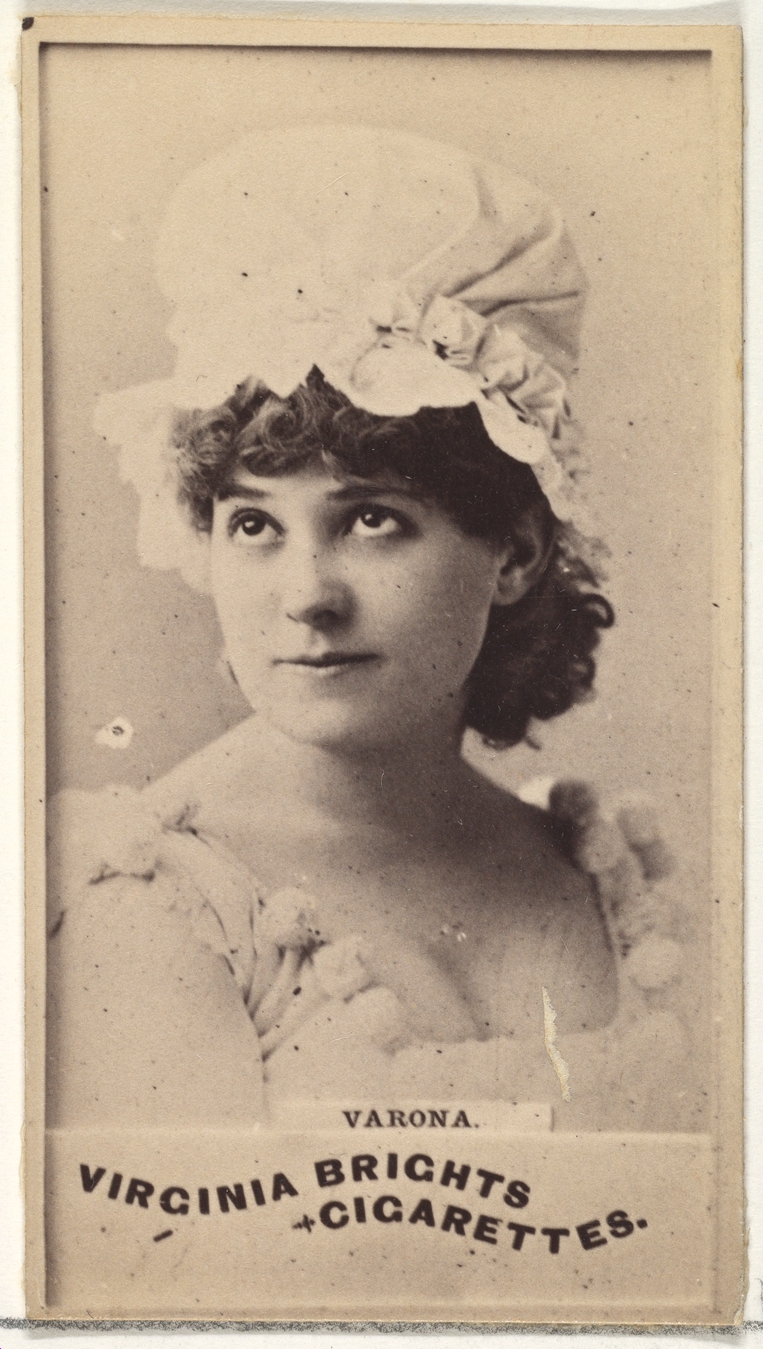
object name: photograph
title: Varona, from the Actors and Actresses series (N45, Type 1) for Virginia Brights Cigarettes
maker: allen & ginter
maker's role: publisher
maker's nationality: american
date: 1888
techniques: albumen silver print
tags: portraits,women,actresses